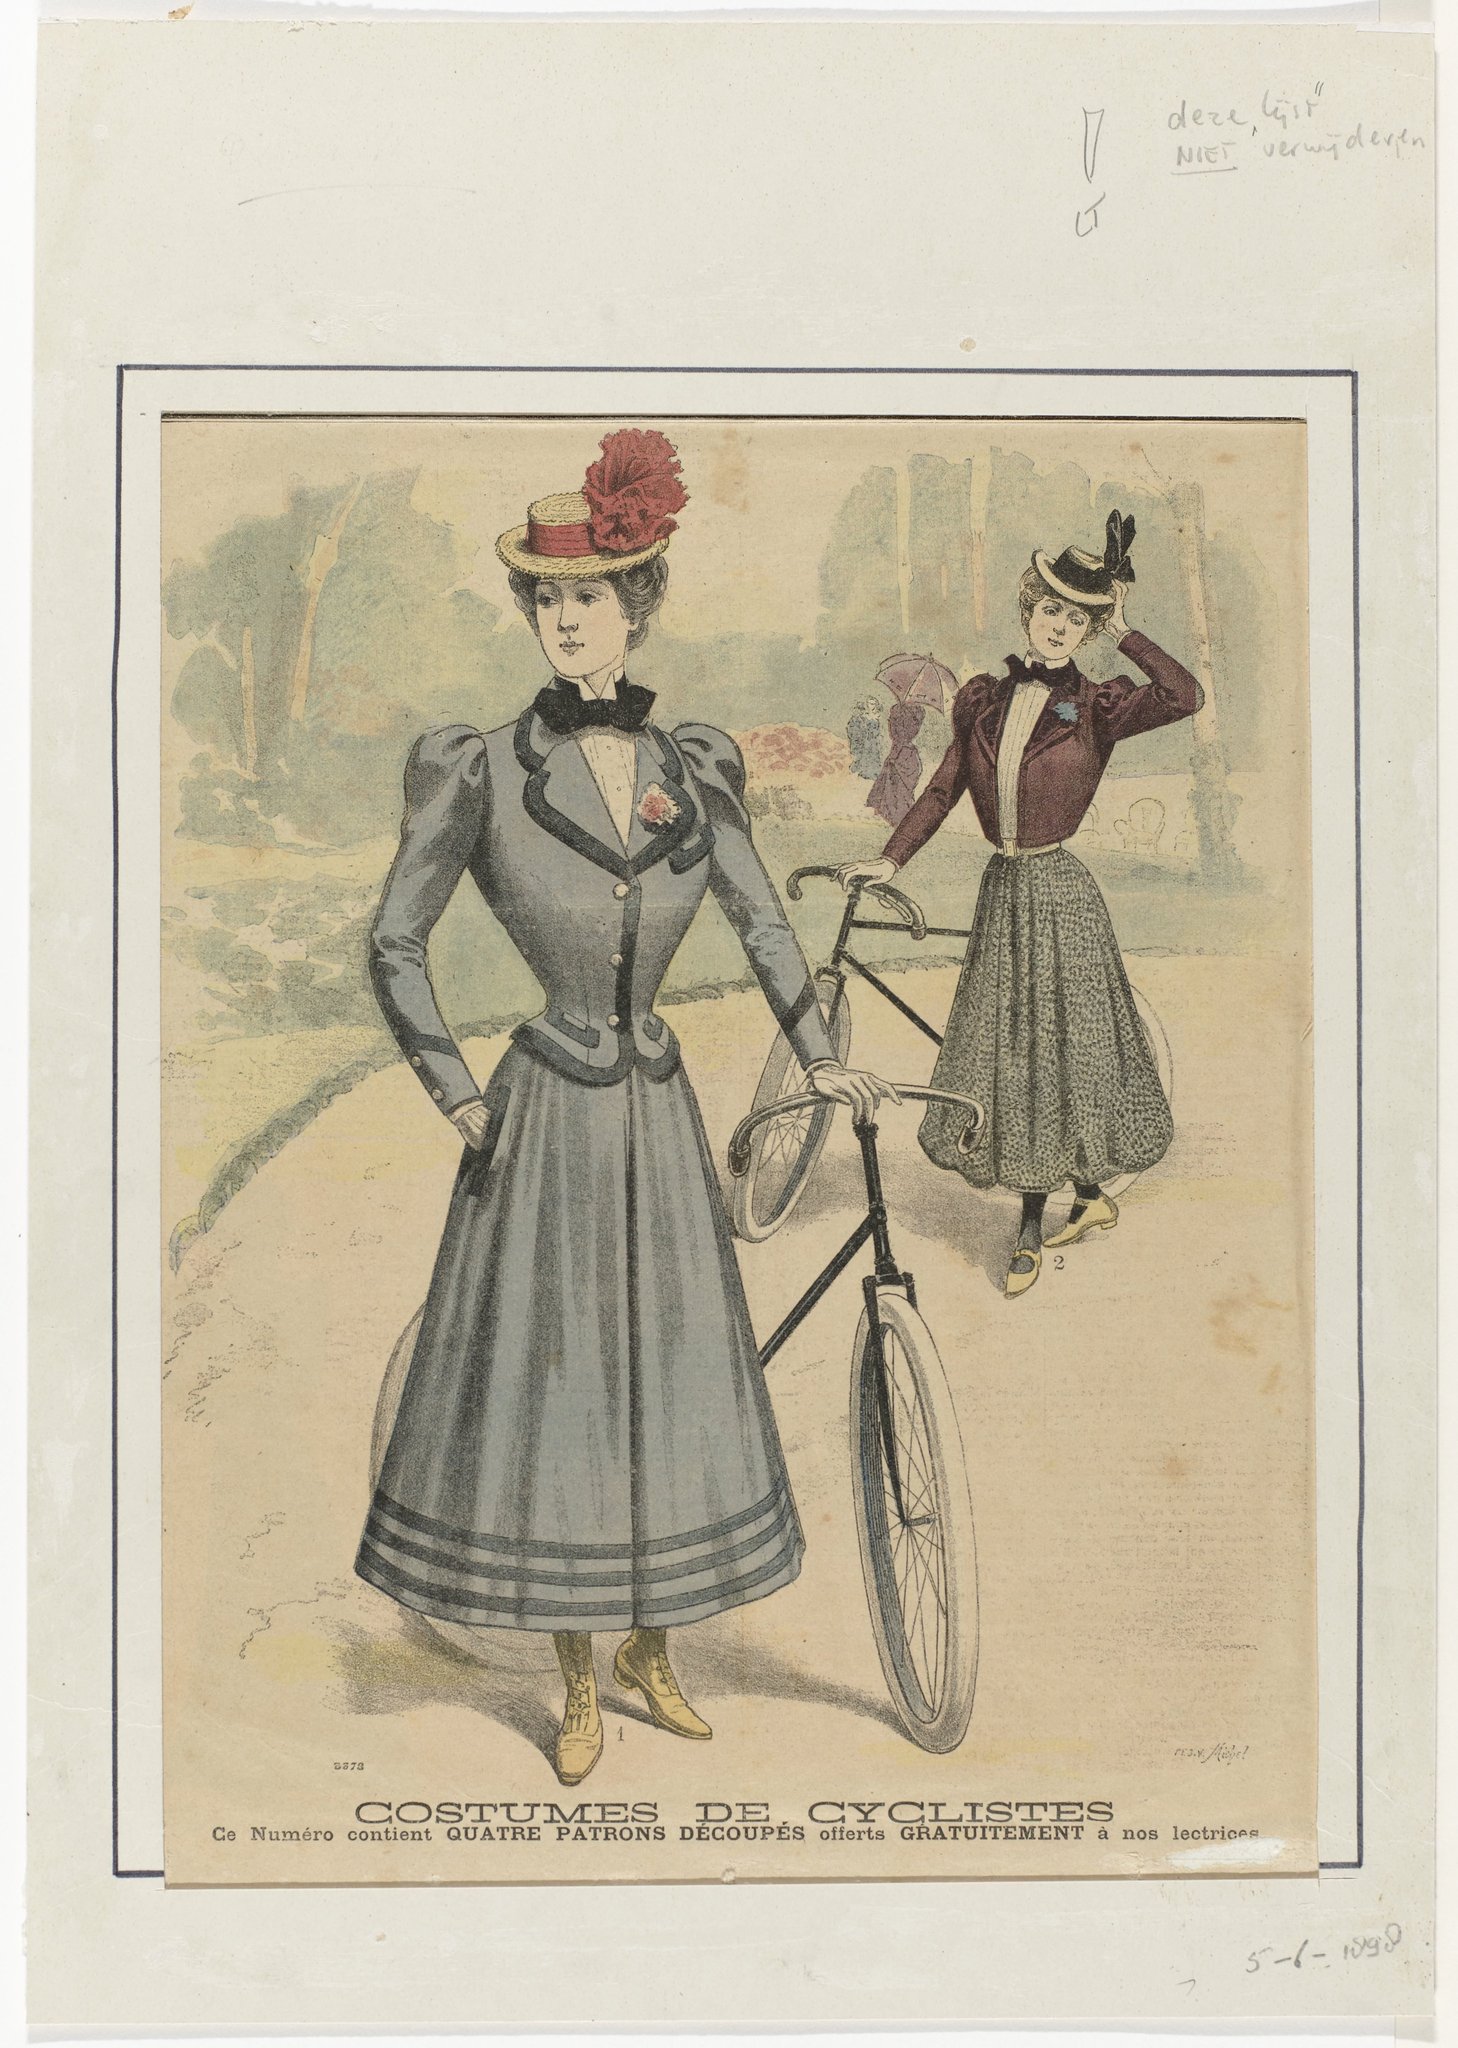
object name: fashion print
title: Costumes de Cyclistes 5-6-1898, nr. 3373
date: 1898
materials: paper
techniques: hand coloring, lithograph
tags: fashion, clothing, fashion plates, head-gear: hat (+ women's clothes), shoes, sandals (+ women's clothes), bicycle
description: Twee vrouwen in fietskleding anno 1898. Zij dragen een kort jasje op wijd vallende rok tot de enkels. Strohoed met veer.